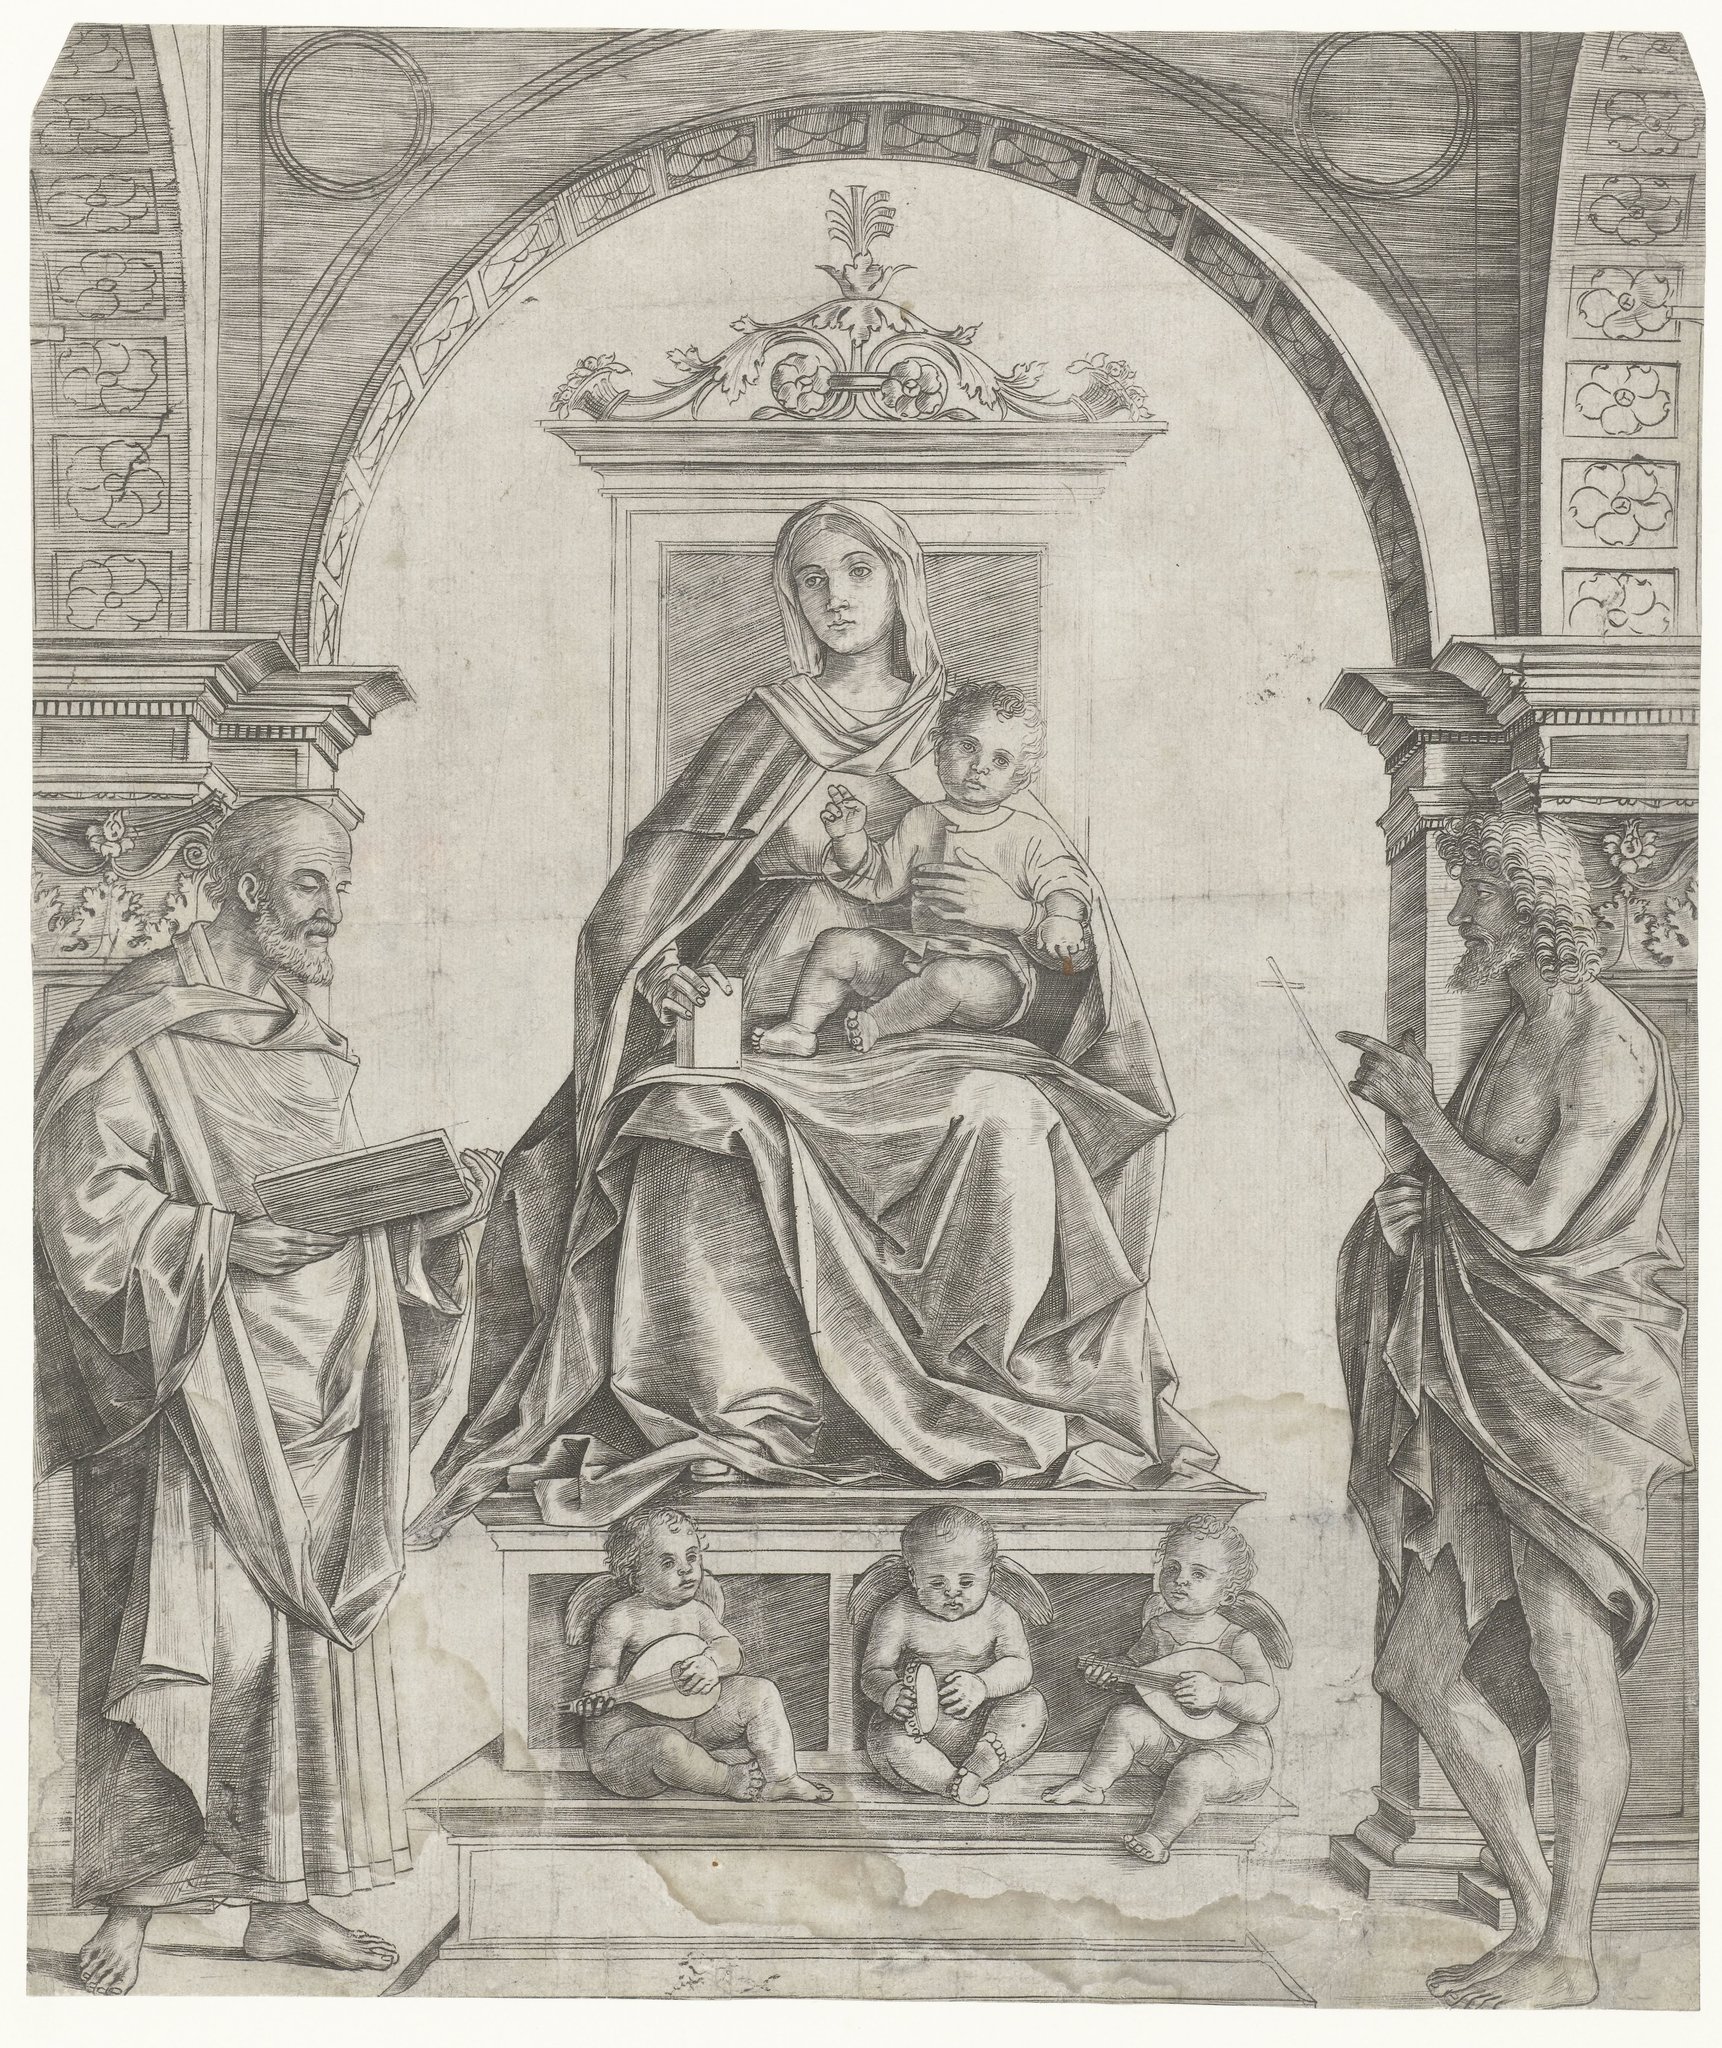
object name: print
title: Maria met kind zittend op een troon tussen Petrus en Johannes de Doper met musicerende engelen en drie vrouwelijke heiligen op de achtergrond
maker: girolamo mocetto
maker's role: print maker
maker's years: 1458-1531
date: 1480-1531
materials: paper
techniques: engraving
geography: italy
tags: angels singing, making music, 'sacra conversazione'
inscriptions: collector's mark: Lugt 240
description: Maria met kind zittend op een troon tussen Petrus of mannelijke heilige en Johannes de Doper. Drie musicerende engelen zitten op trede van troon. Drie vrouwelijke heiligen staan achter de troon.